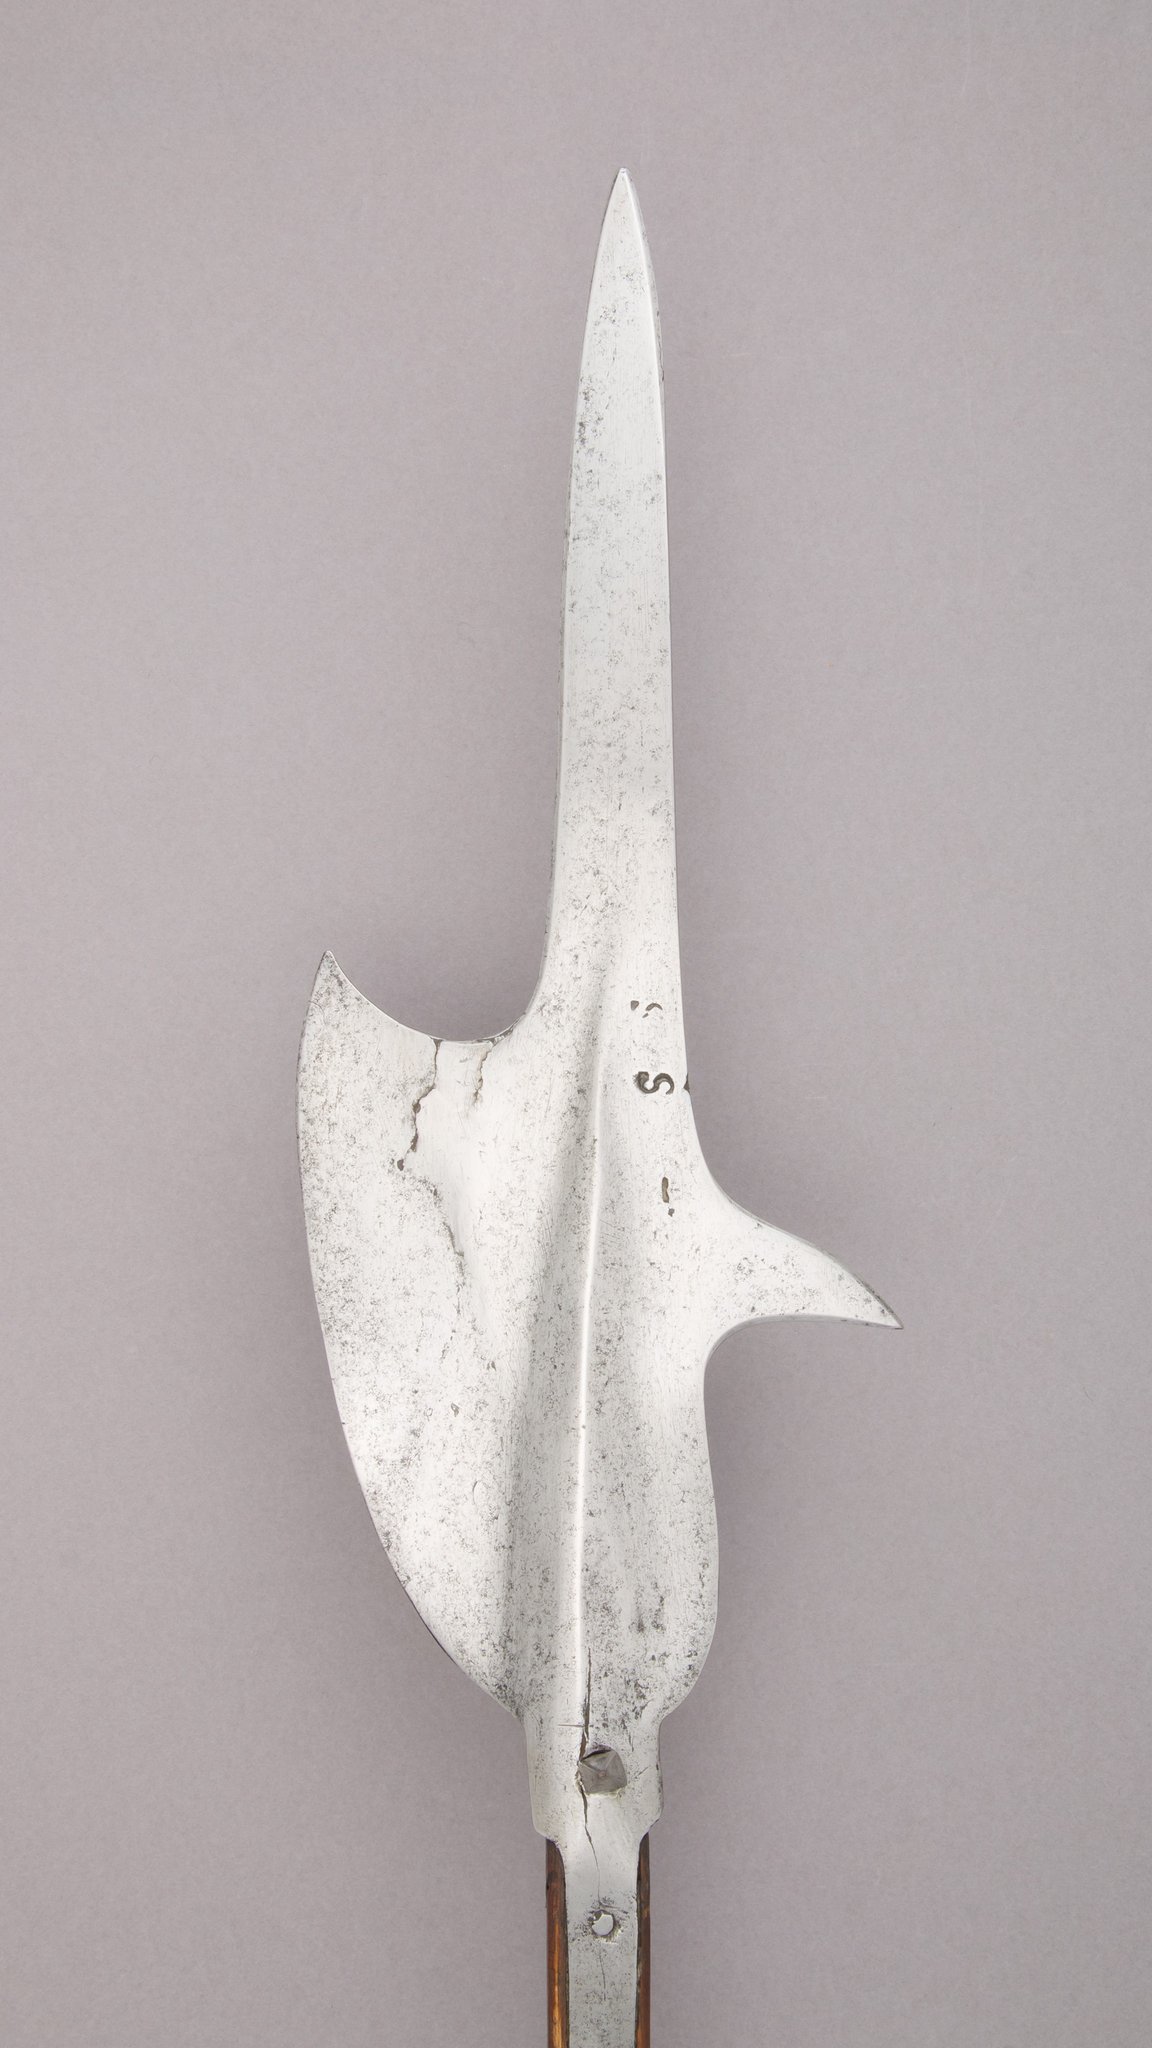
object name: halberd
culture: german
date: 1640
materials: steel, wood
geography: germany